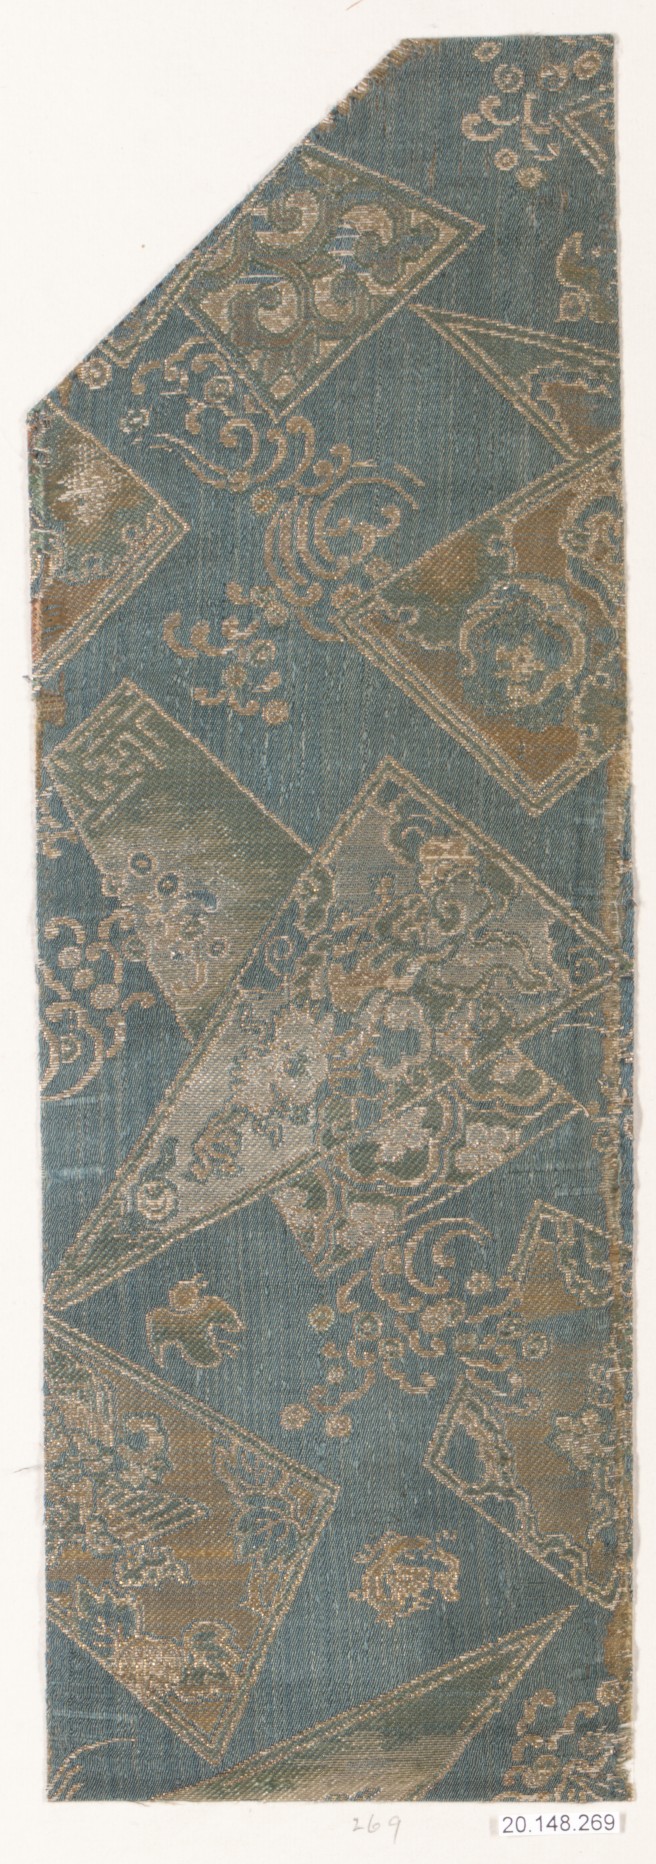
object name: piece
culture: japanese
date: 1601-1700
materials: silk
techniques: compound weave